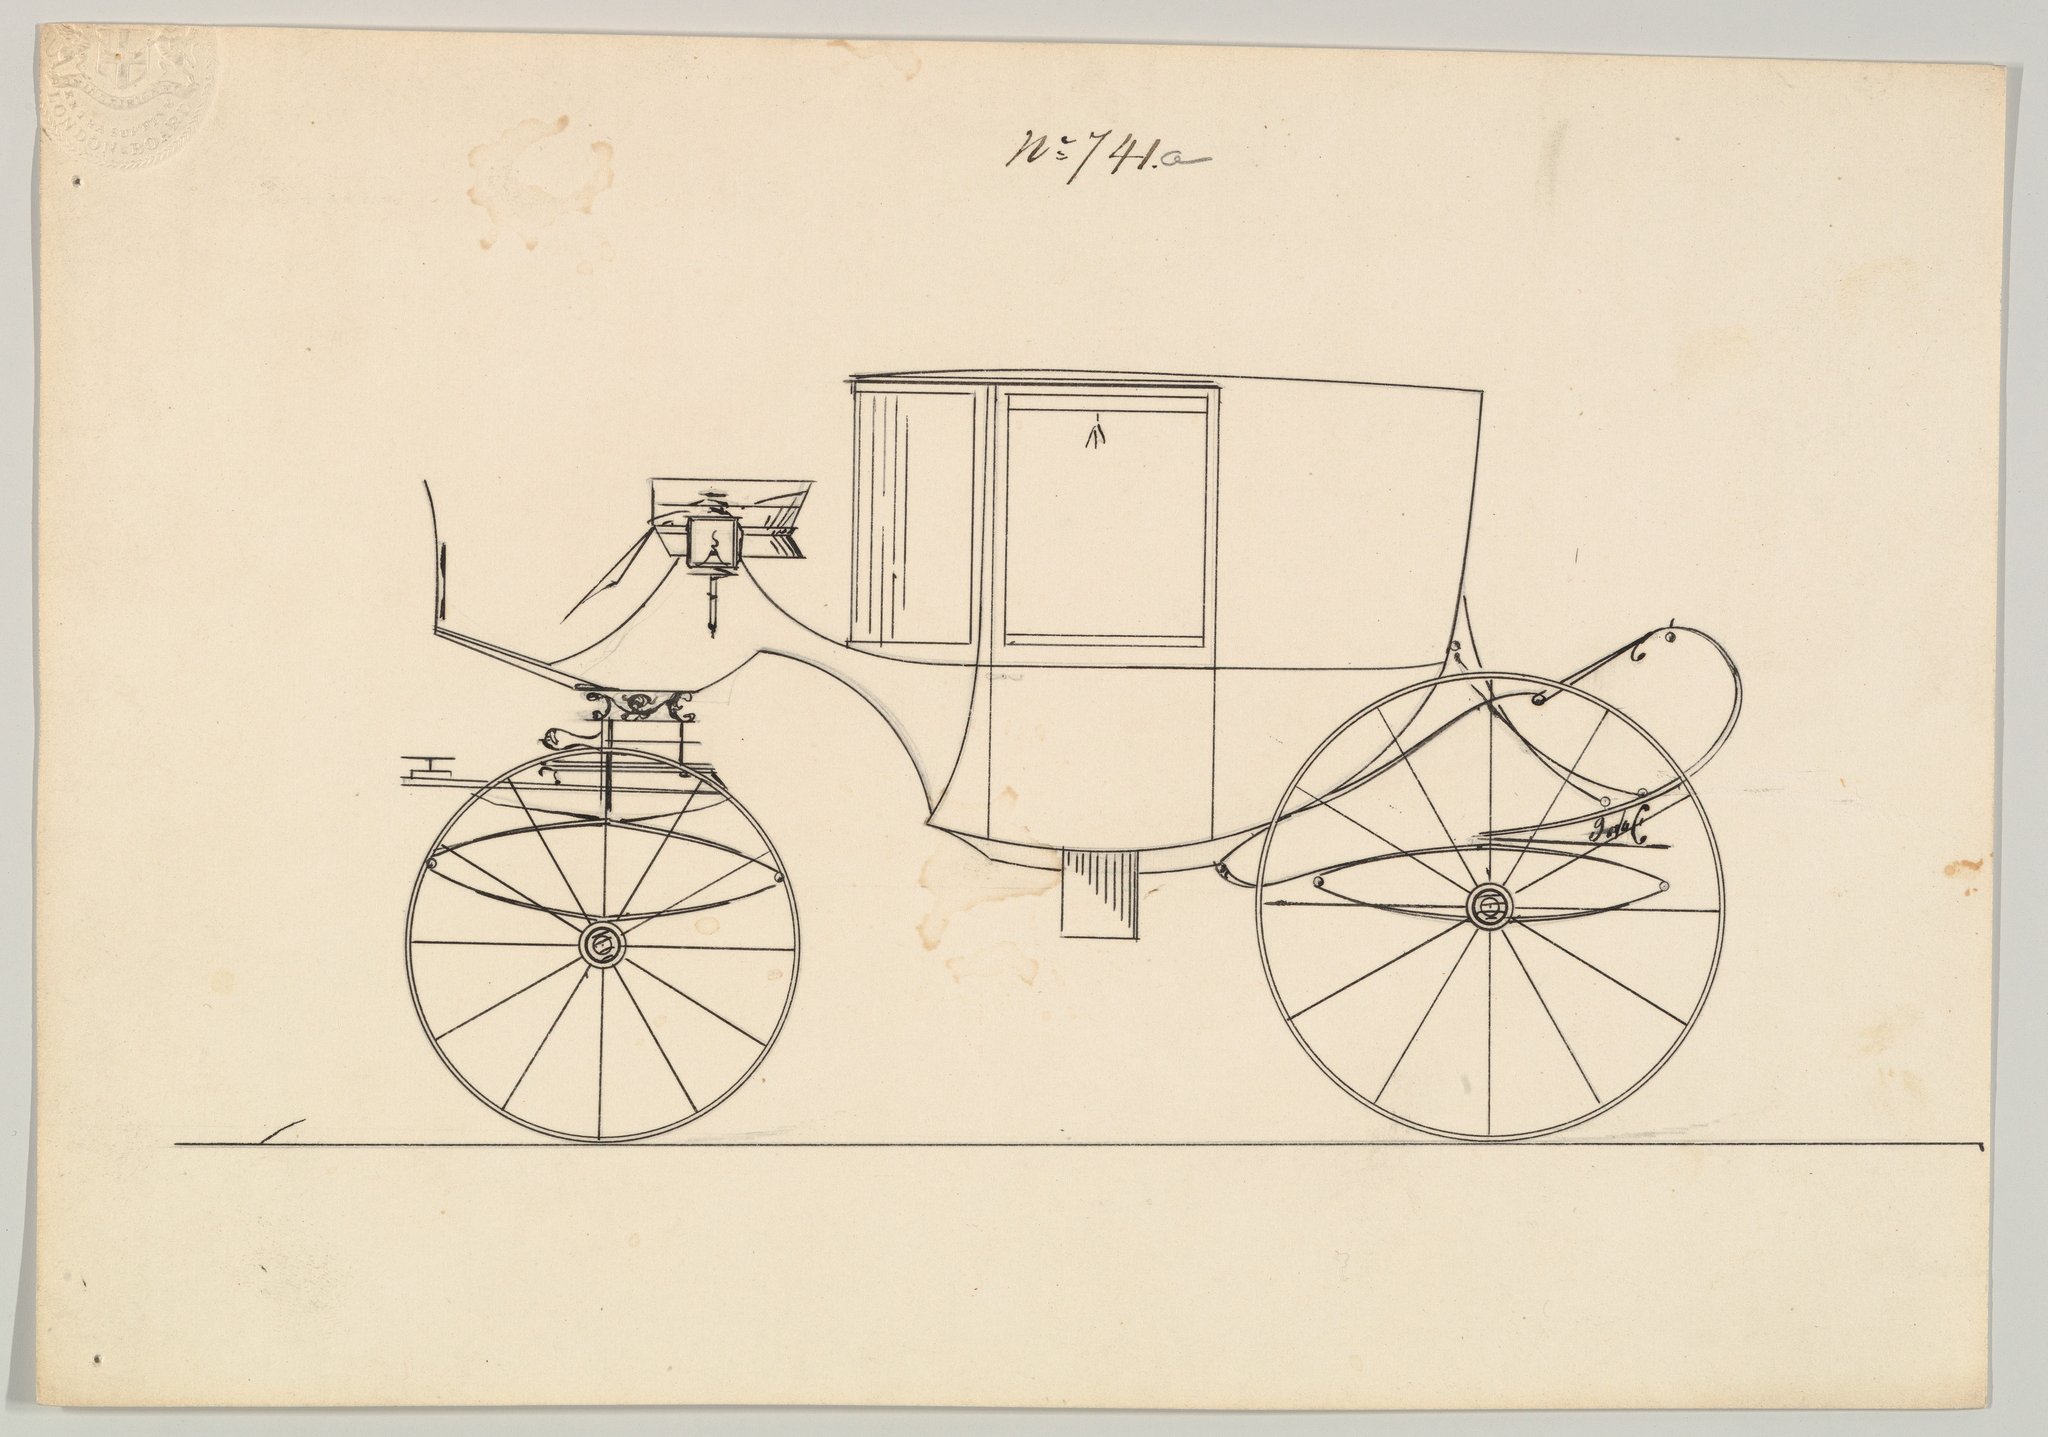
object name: drawing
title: Coupé # 741a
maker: brewster & co.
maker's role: manufacturer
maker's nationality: american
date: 1850-1870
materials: ink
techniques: pen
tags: carriages